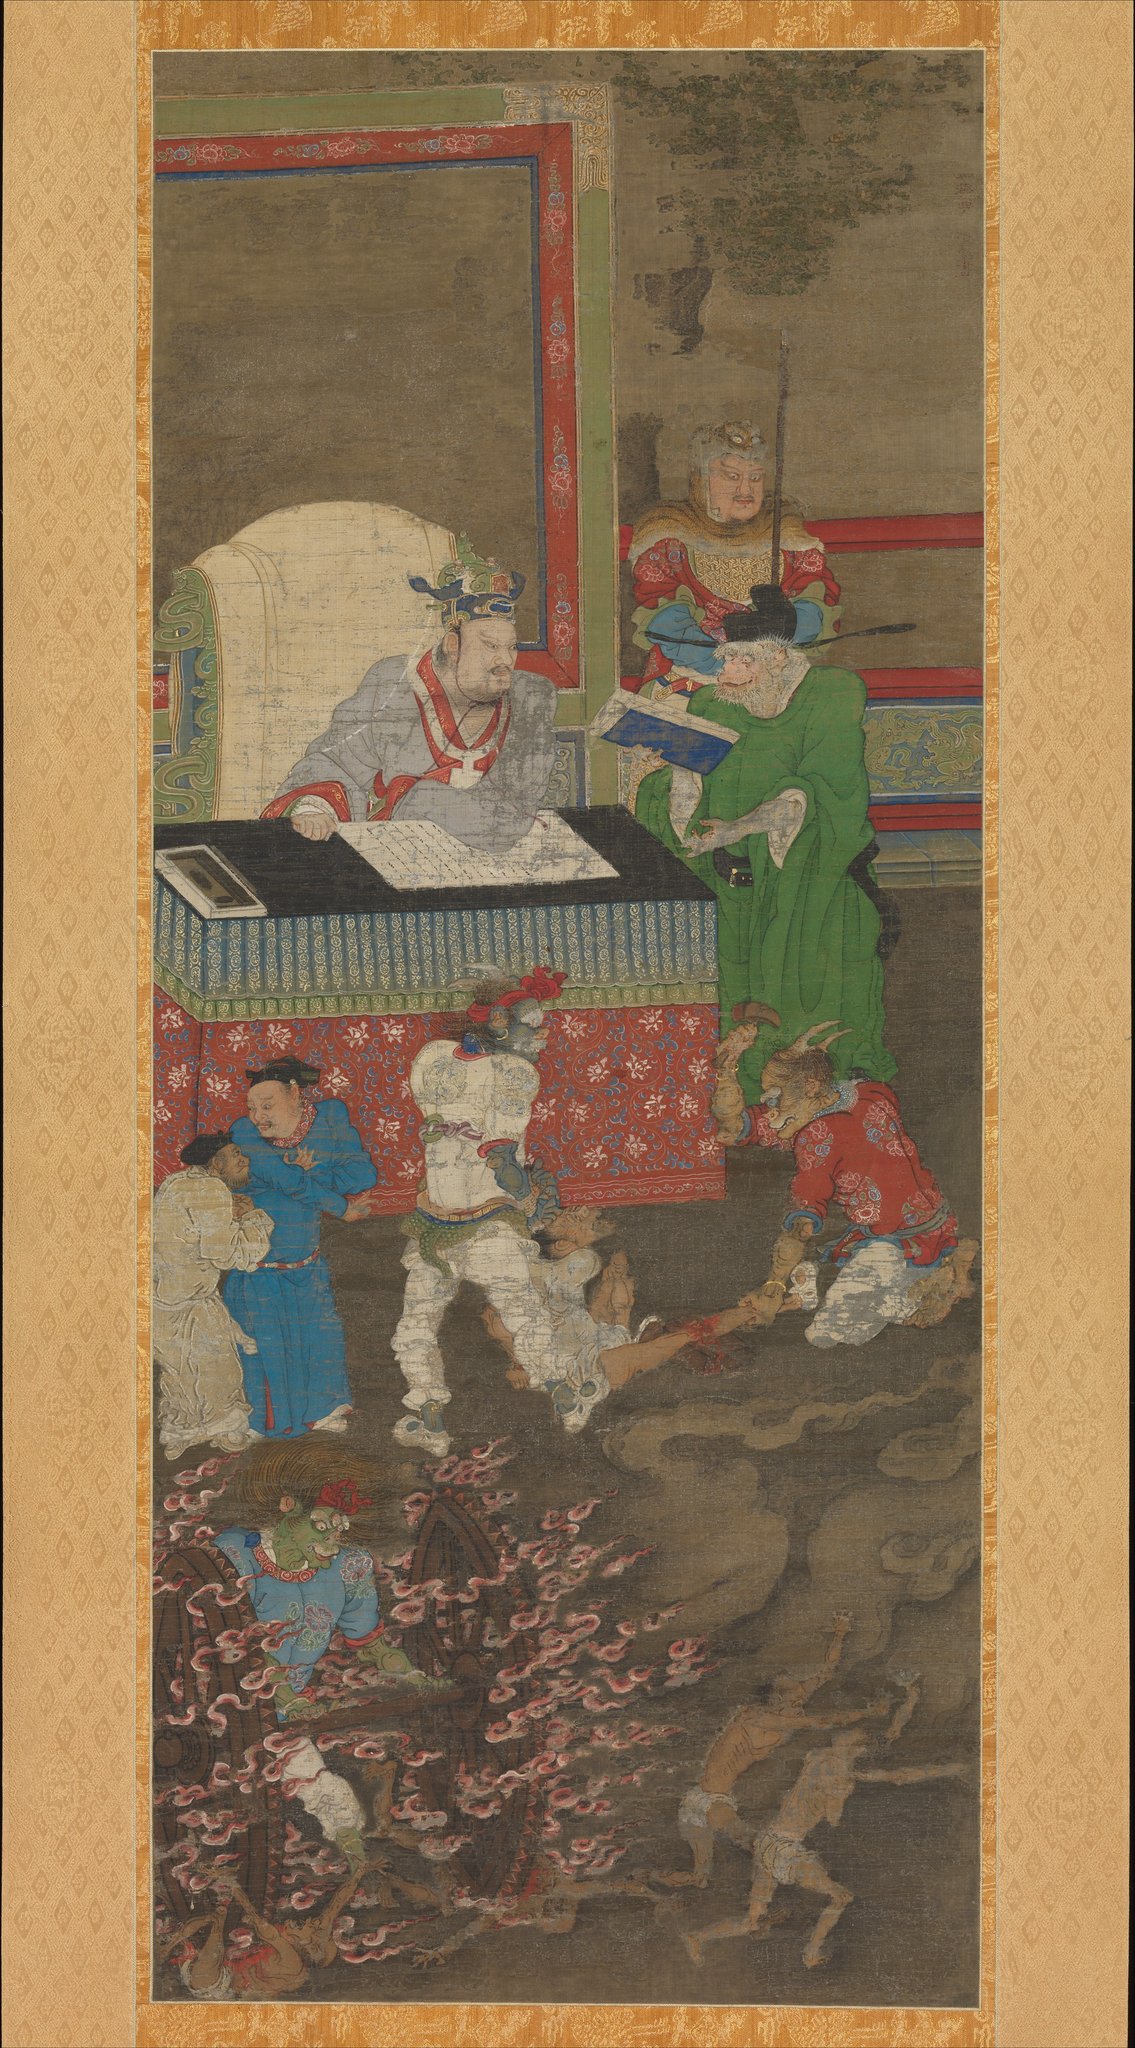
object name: hanging scroll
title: Ten Kings of Hell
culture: chinese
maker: jin chushi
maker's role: artist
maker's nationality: chinese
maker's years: 1167-1199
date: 1195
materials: ink, silk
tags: men,demons,tables